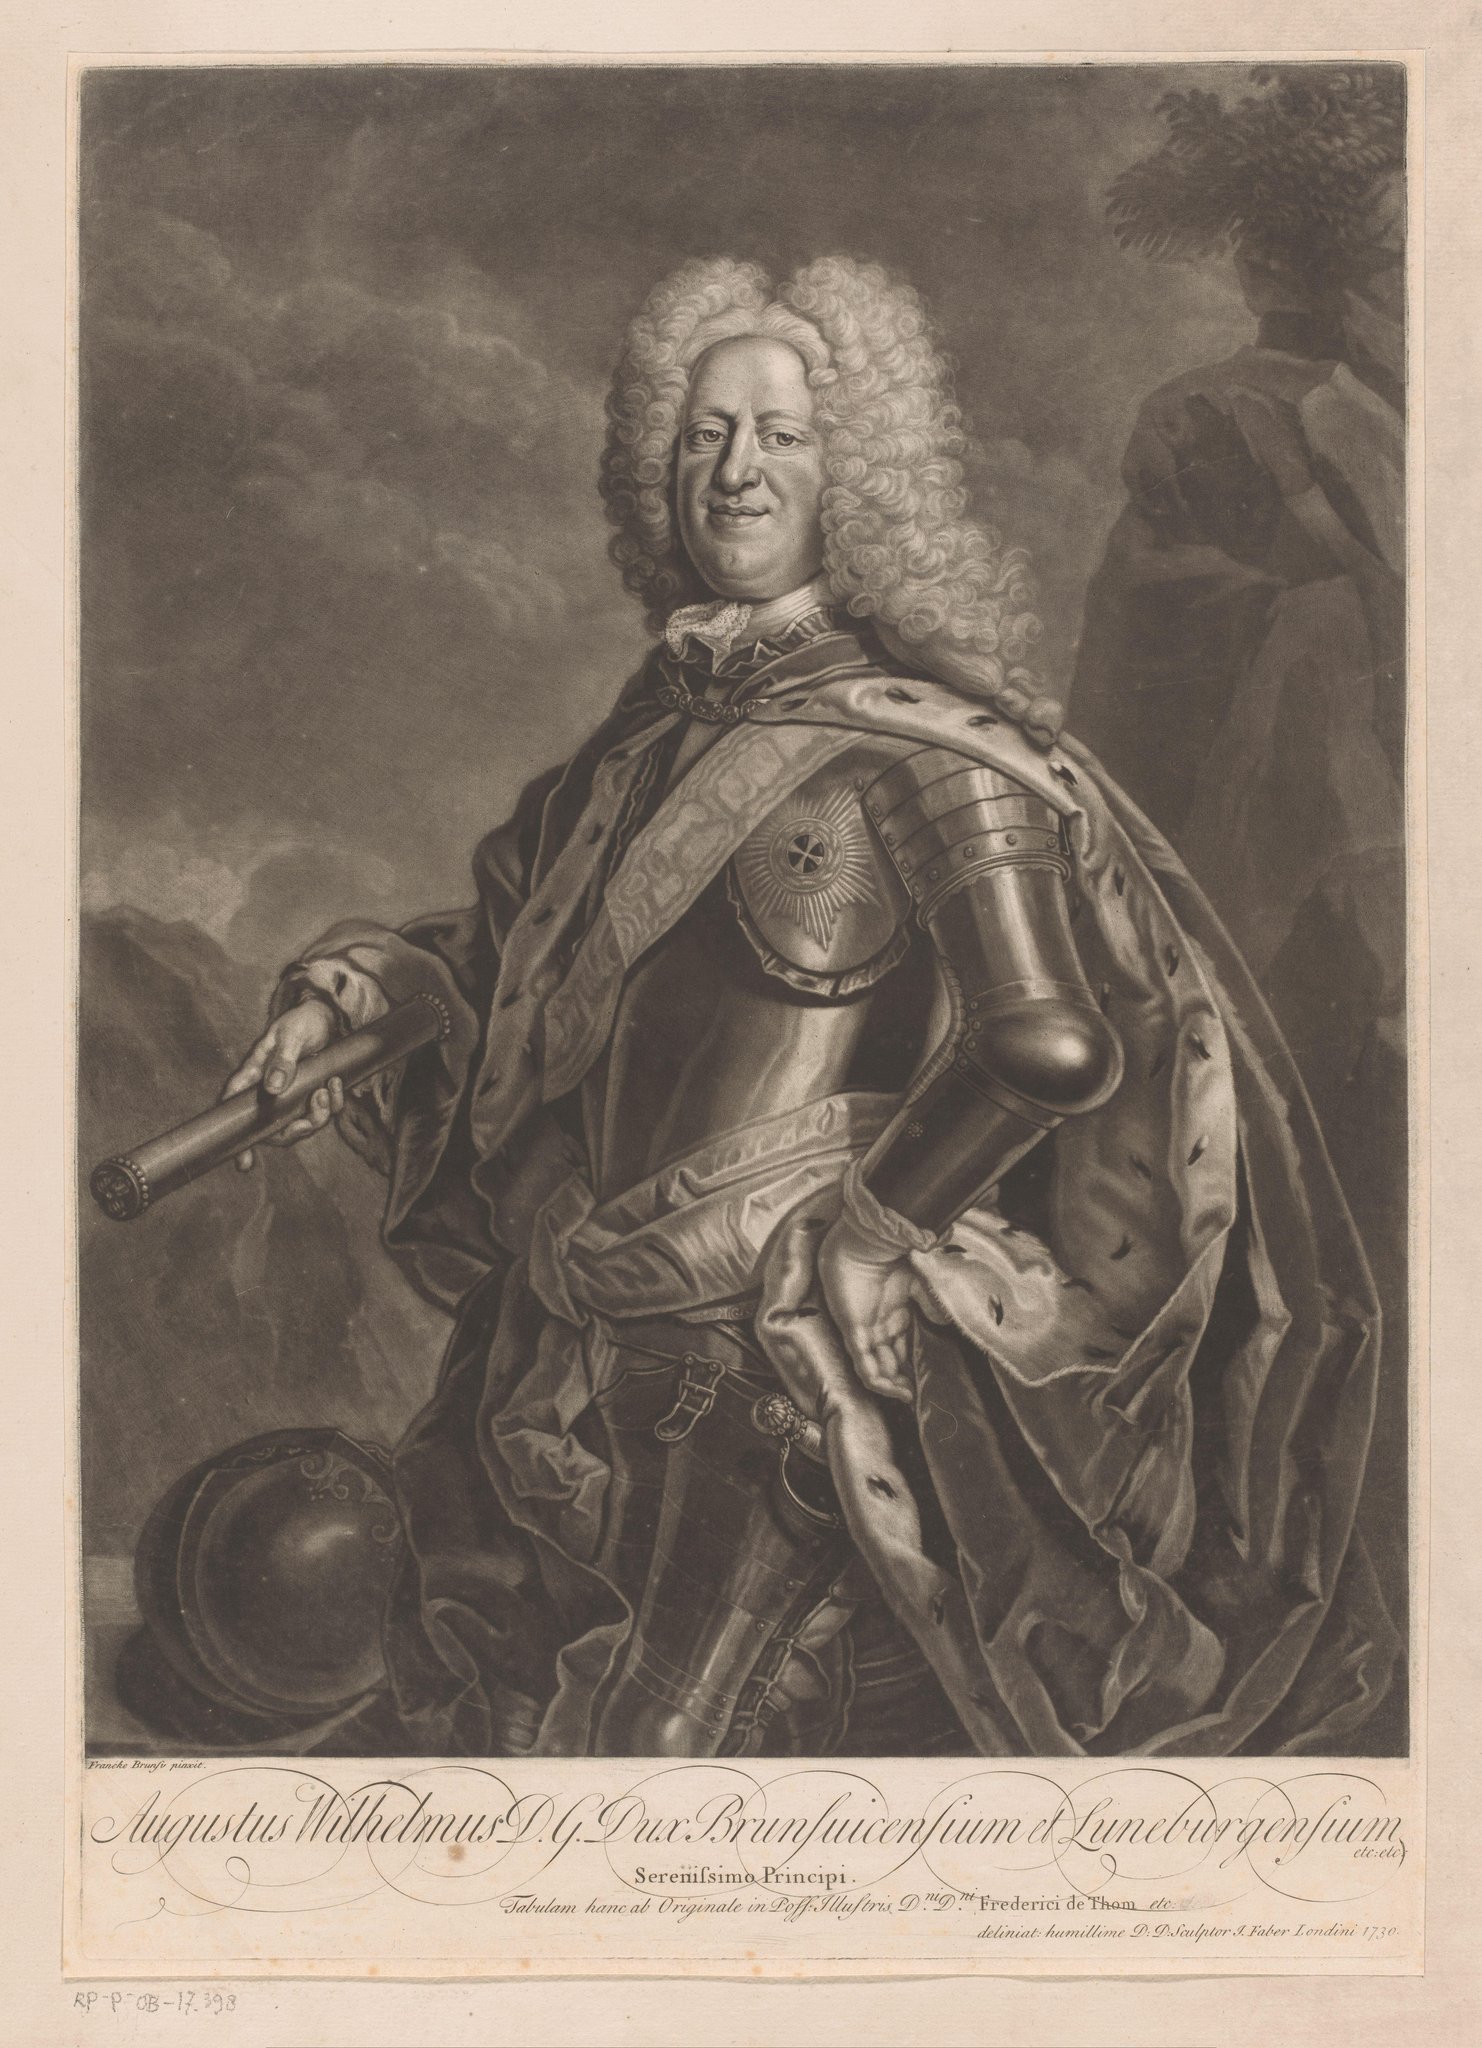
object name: print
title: Portret van August Wilhelm von Braunschweig-Lüneburg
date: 1730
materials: paper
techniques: mezzotint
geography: london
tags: commander-in-chief, general, marshal, historical persons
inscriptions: collector's mark: Lugt 240